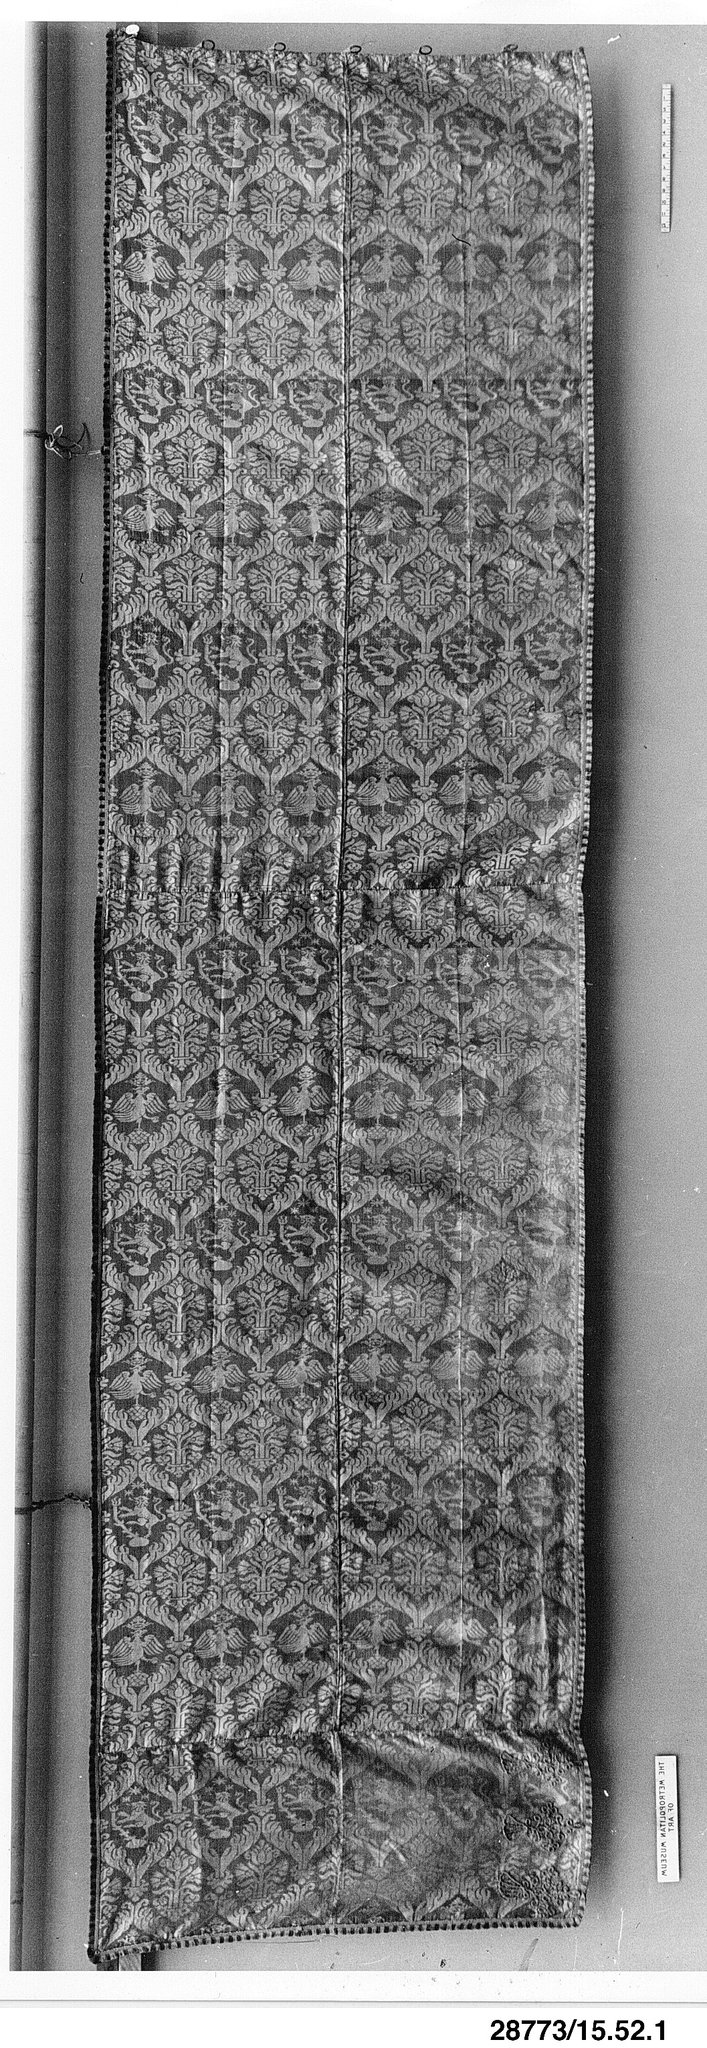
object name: panel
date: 1601-1700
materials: silk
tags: animals,birds